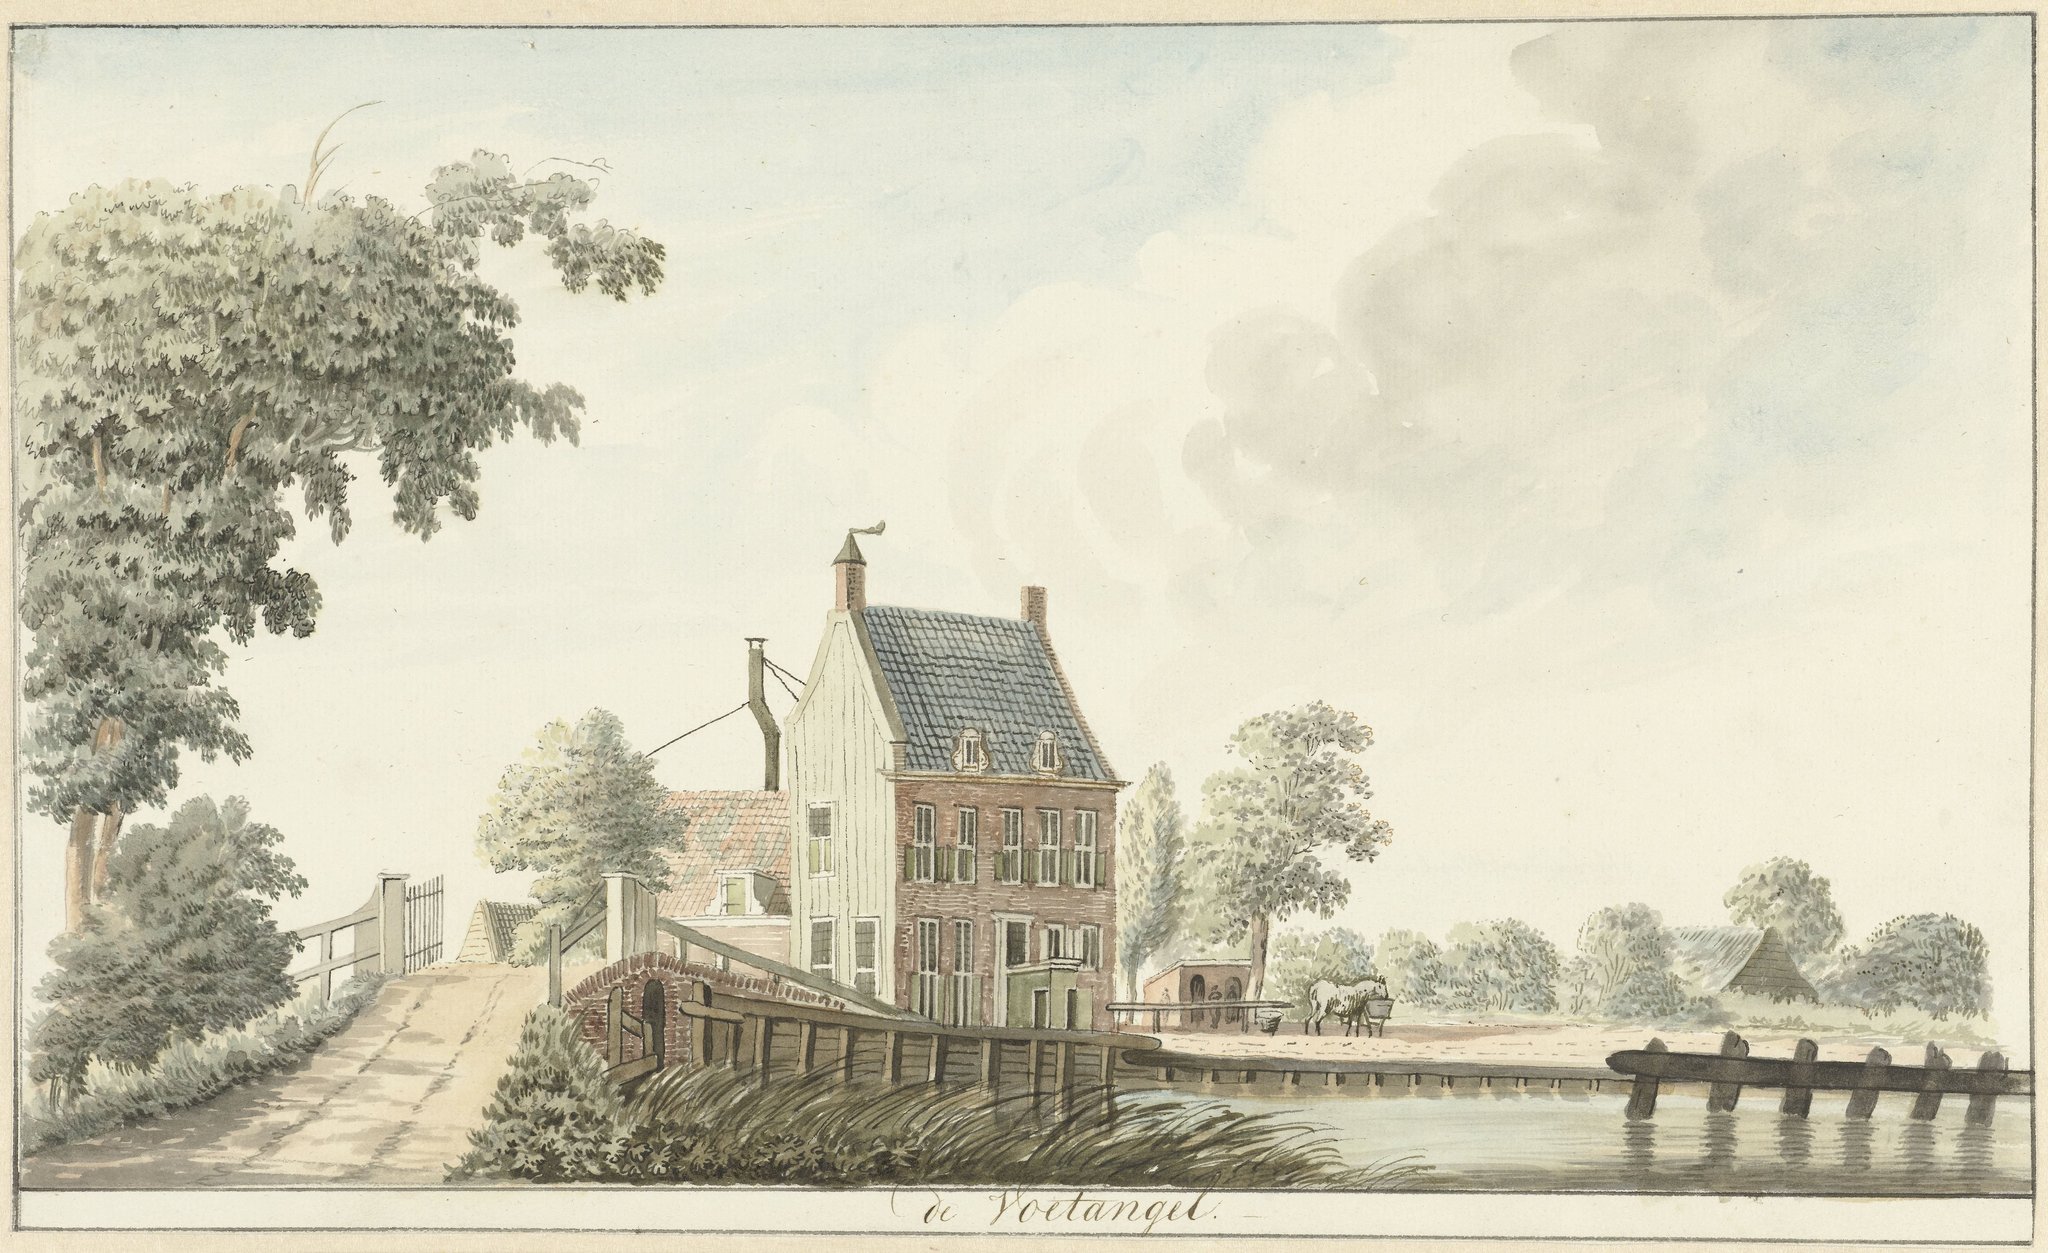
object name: drawing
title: Herberg de Voetangel aan de Utrechtse trekvaart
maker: hendrik tavenier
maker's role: draughtsman, print maker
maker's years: 1734-1807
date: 1782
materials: ink, paper, watercolor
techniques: brush, pen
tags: open hearth, fire-place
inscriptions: inscription: ‘d herberg de voetAngel aan d utregse trekvaart / 1782 / Hendr Tavenier’